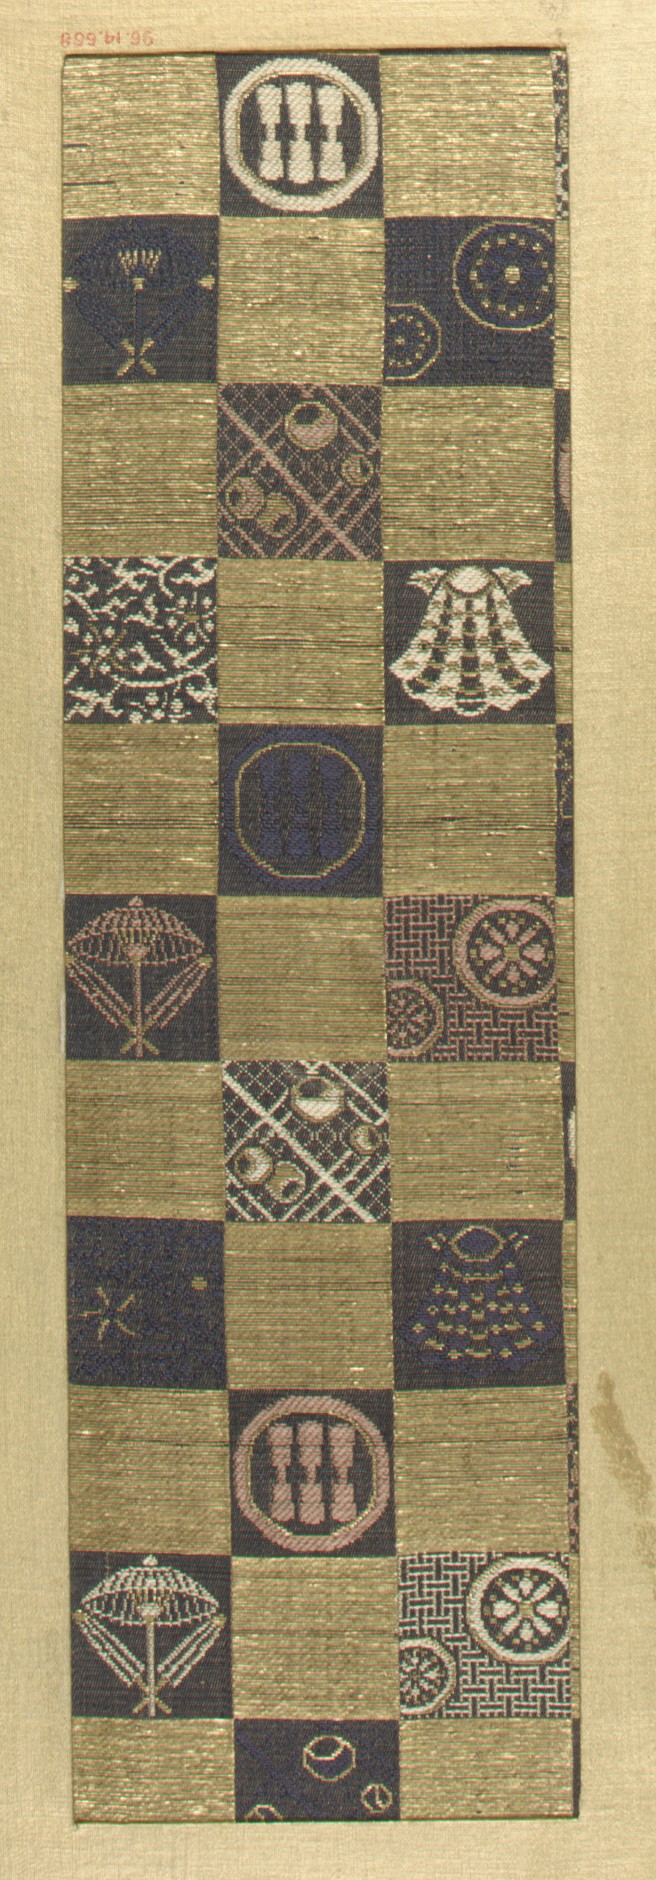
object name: piece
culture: japanese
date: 1701-1900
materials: silk